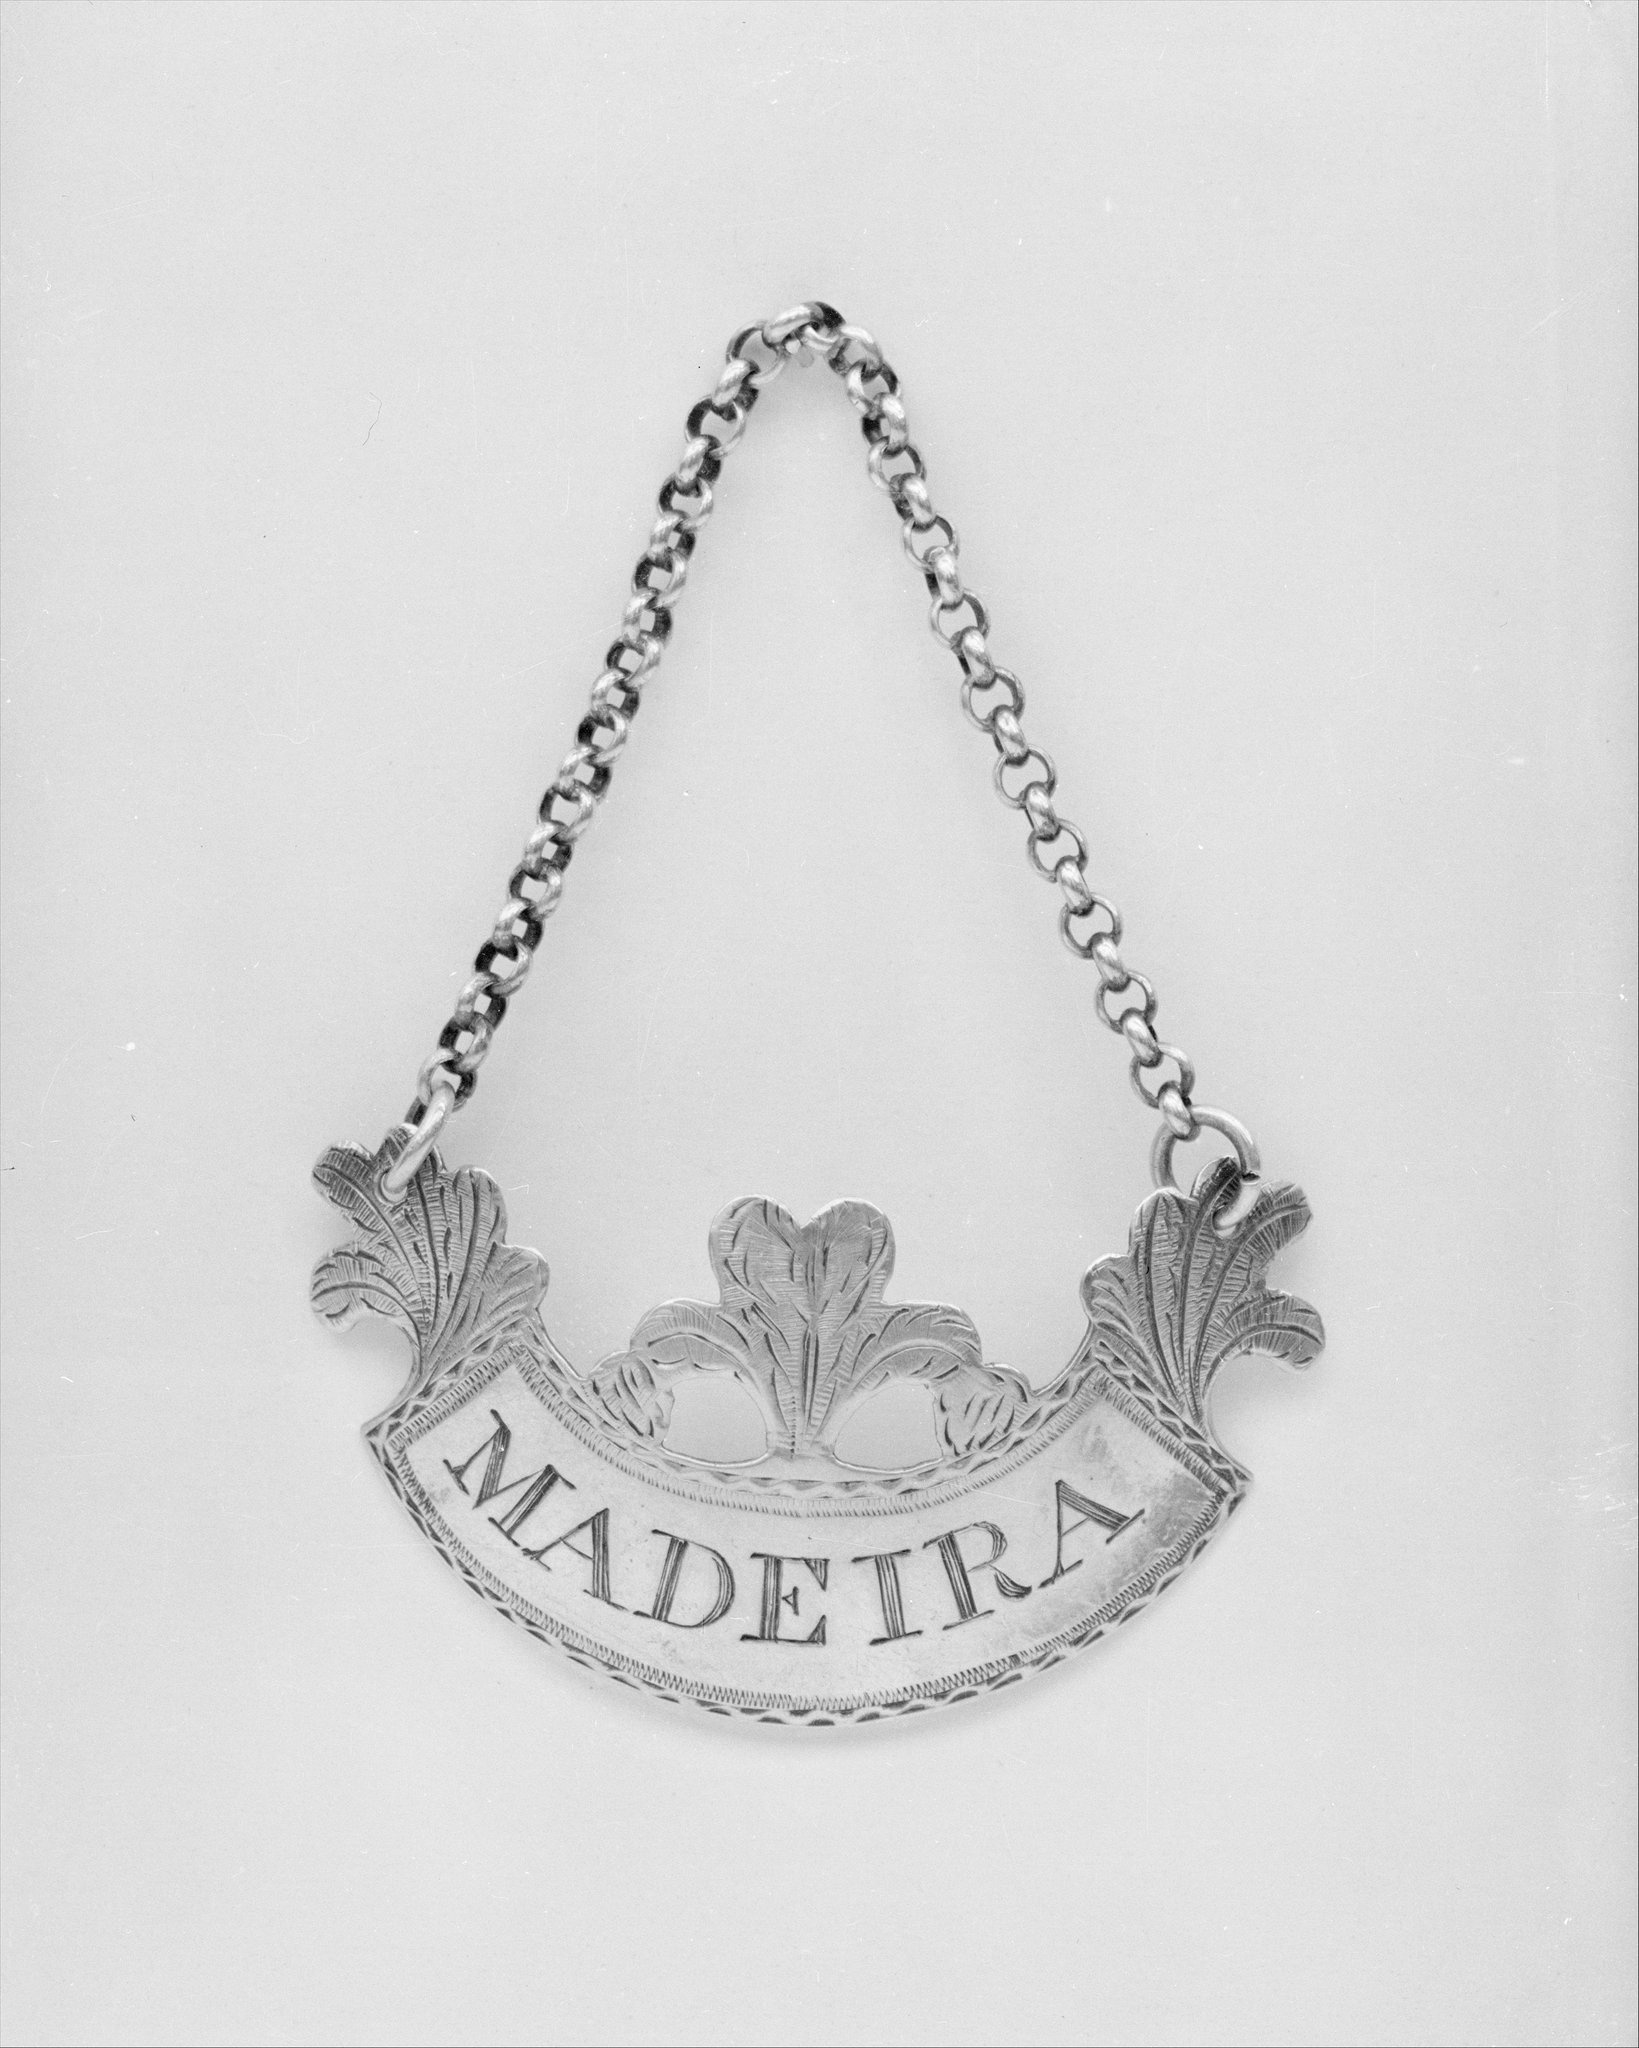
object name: decanter label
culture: american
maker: louis boudo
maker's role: maker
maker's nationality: american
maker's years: 1786-1827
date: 1810-1825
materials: silver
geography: united states